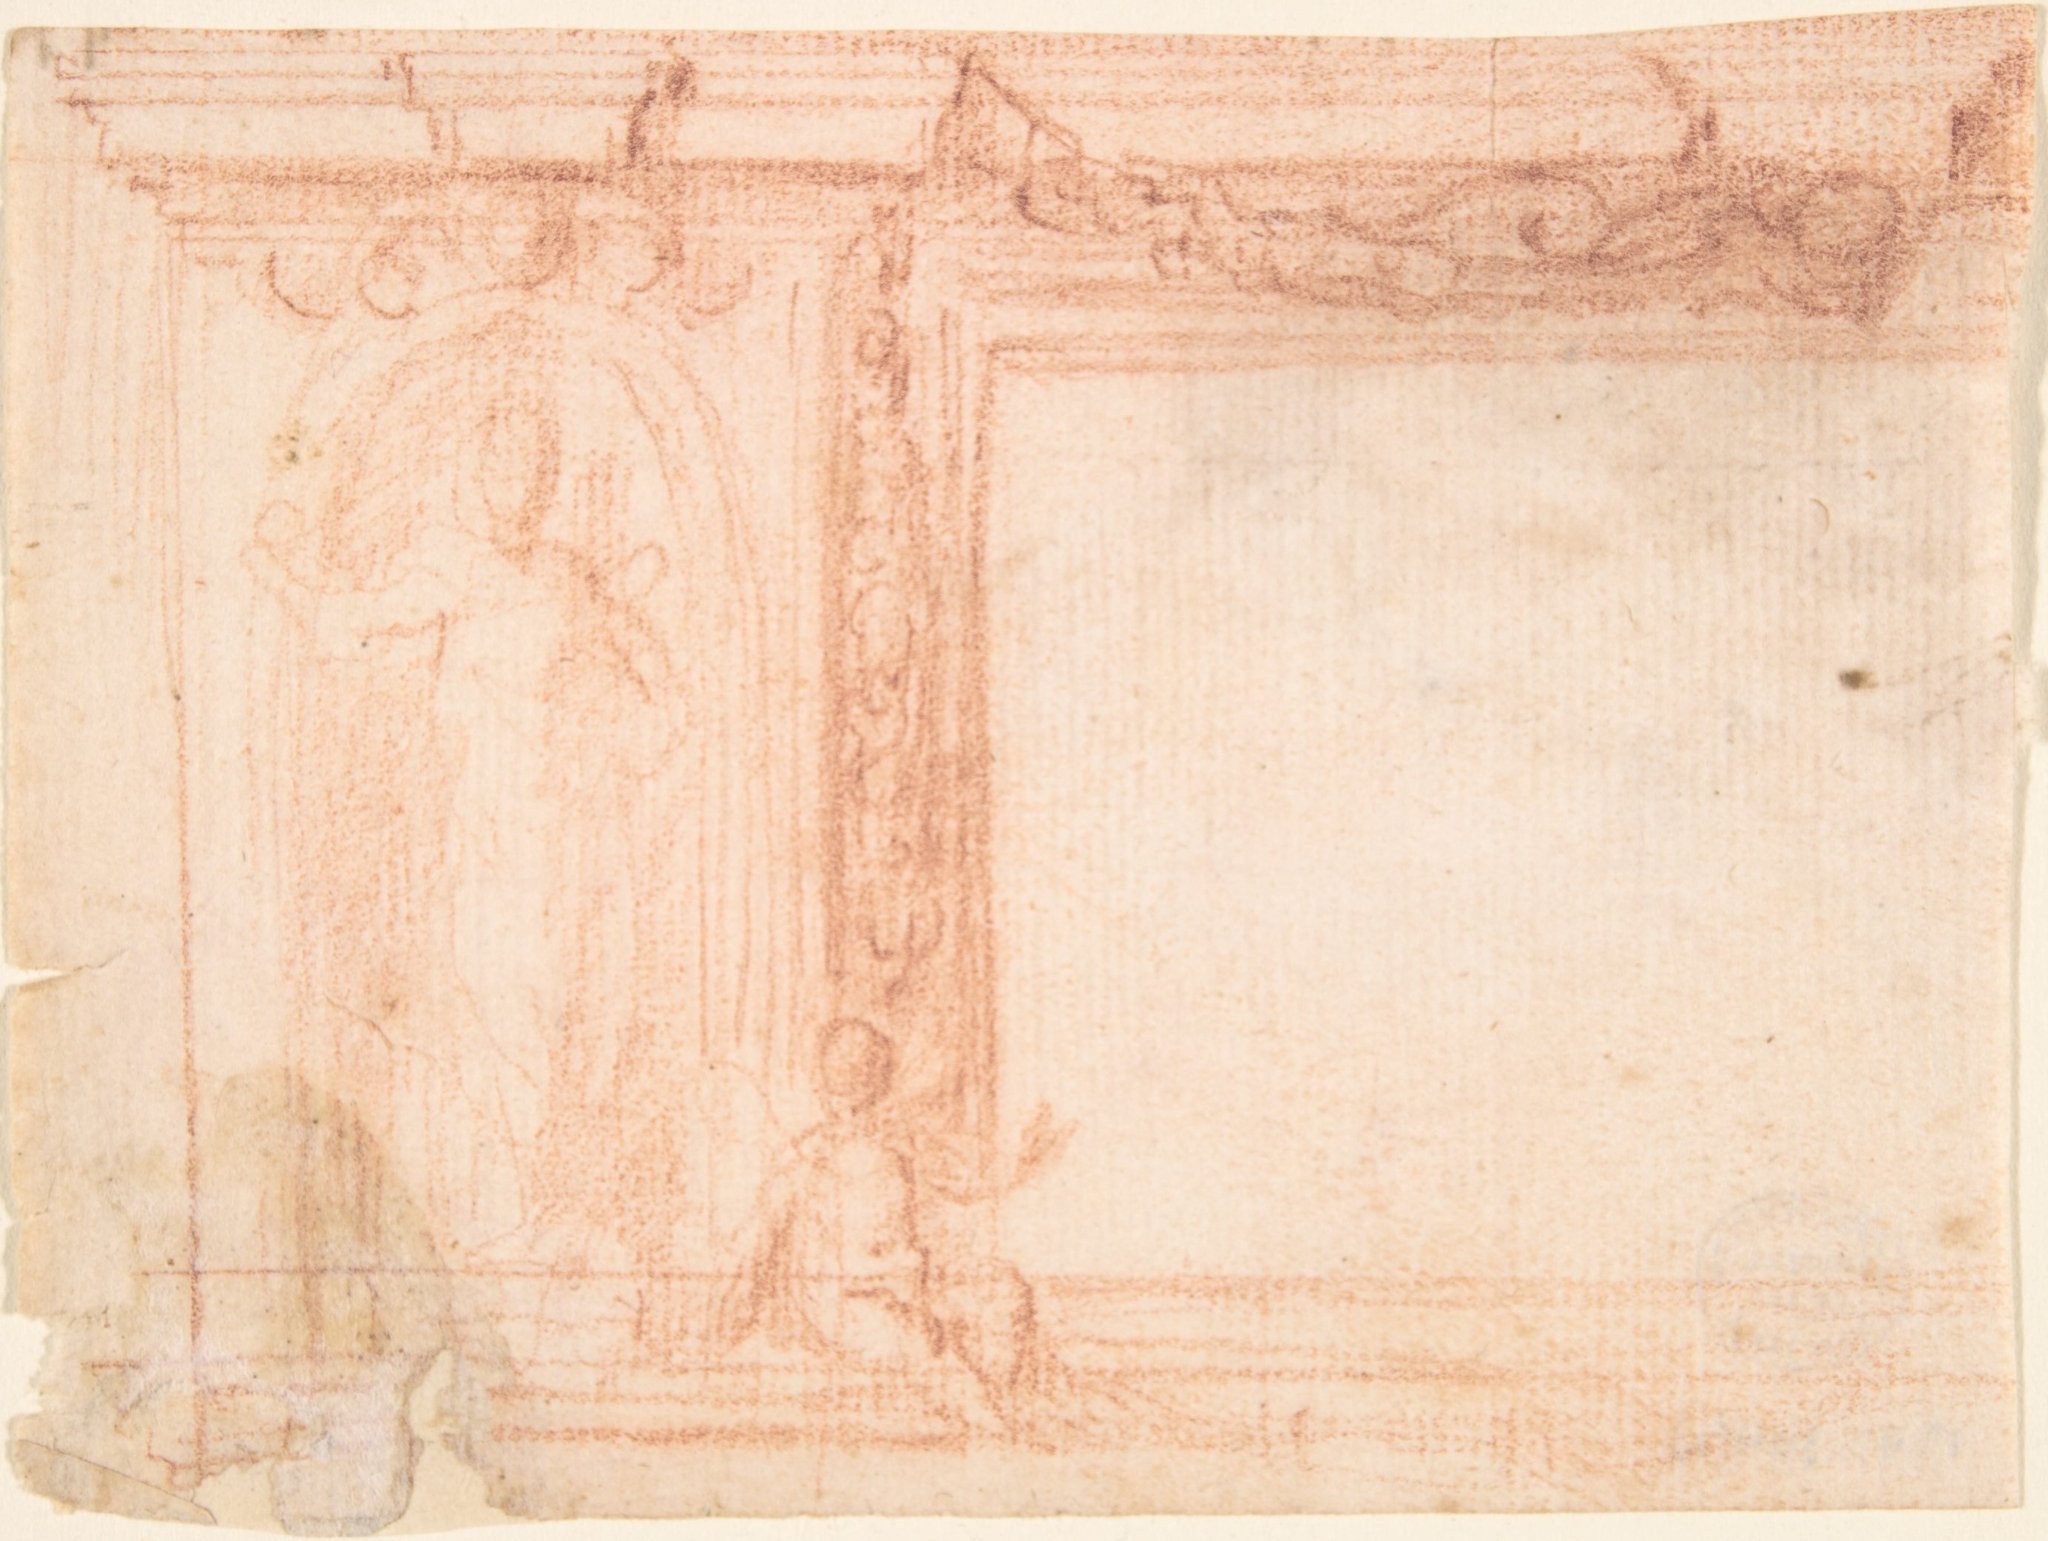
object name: drawing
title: Sketch for a Wall Decoration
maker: anonymous, italian, 17th century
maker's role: artist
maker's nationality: italian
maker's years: 1600-1700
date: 1601-1700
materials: chalk